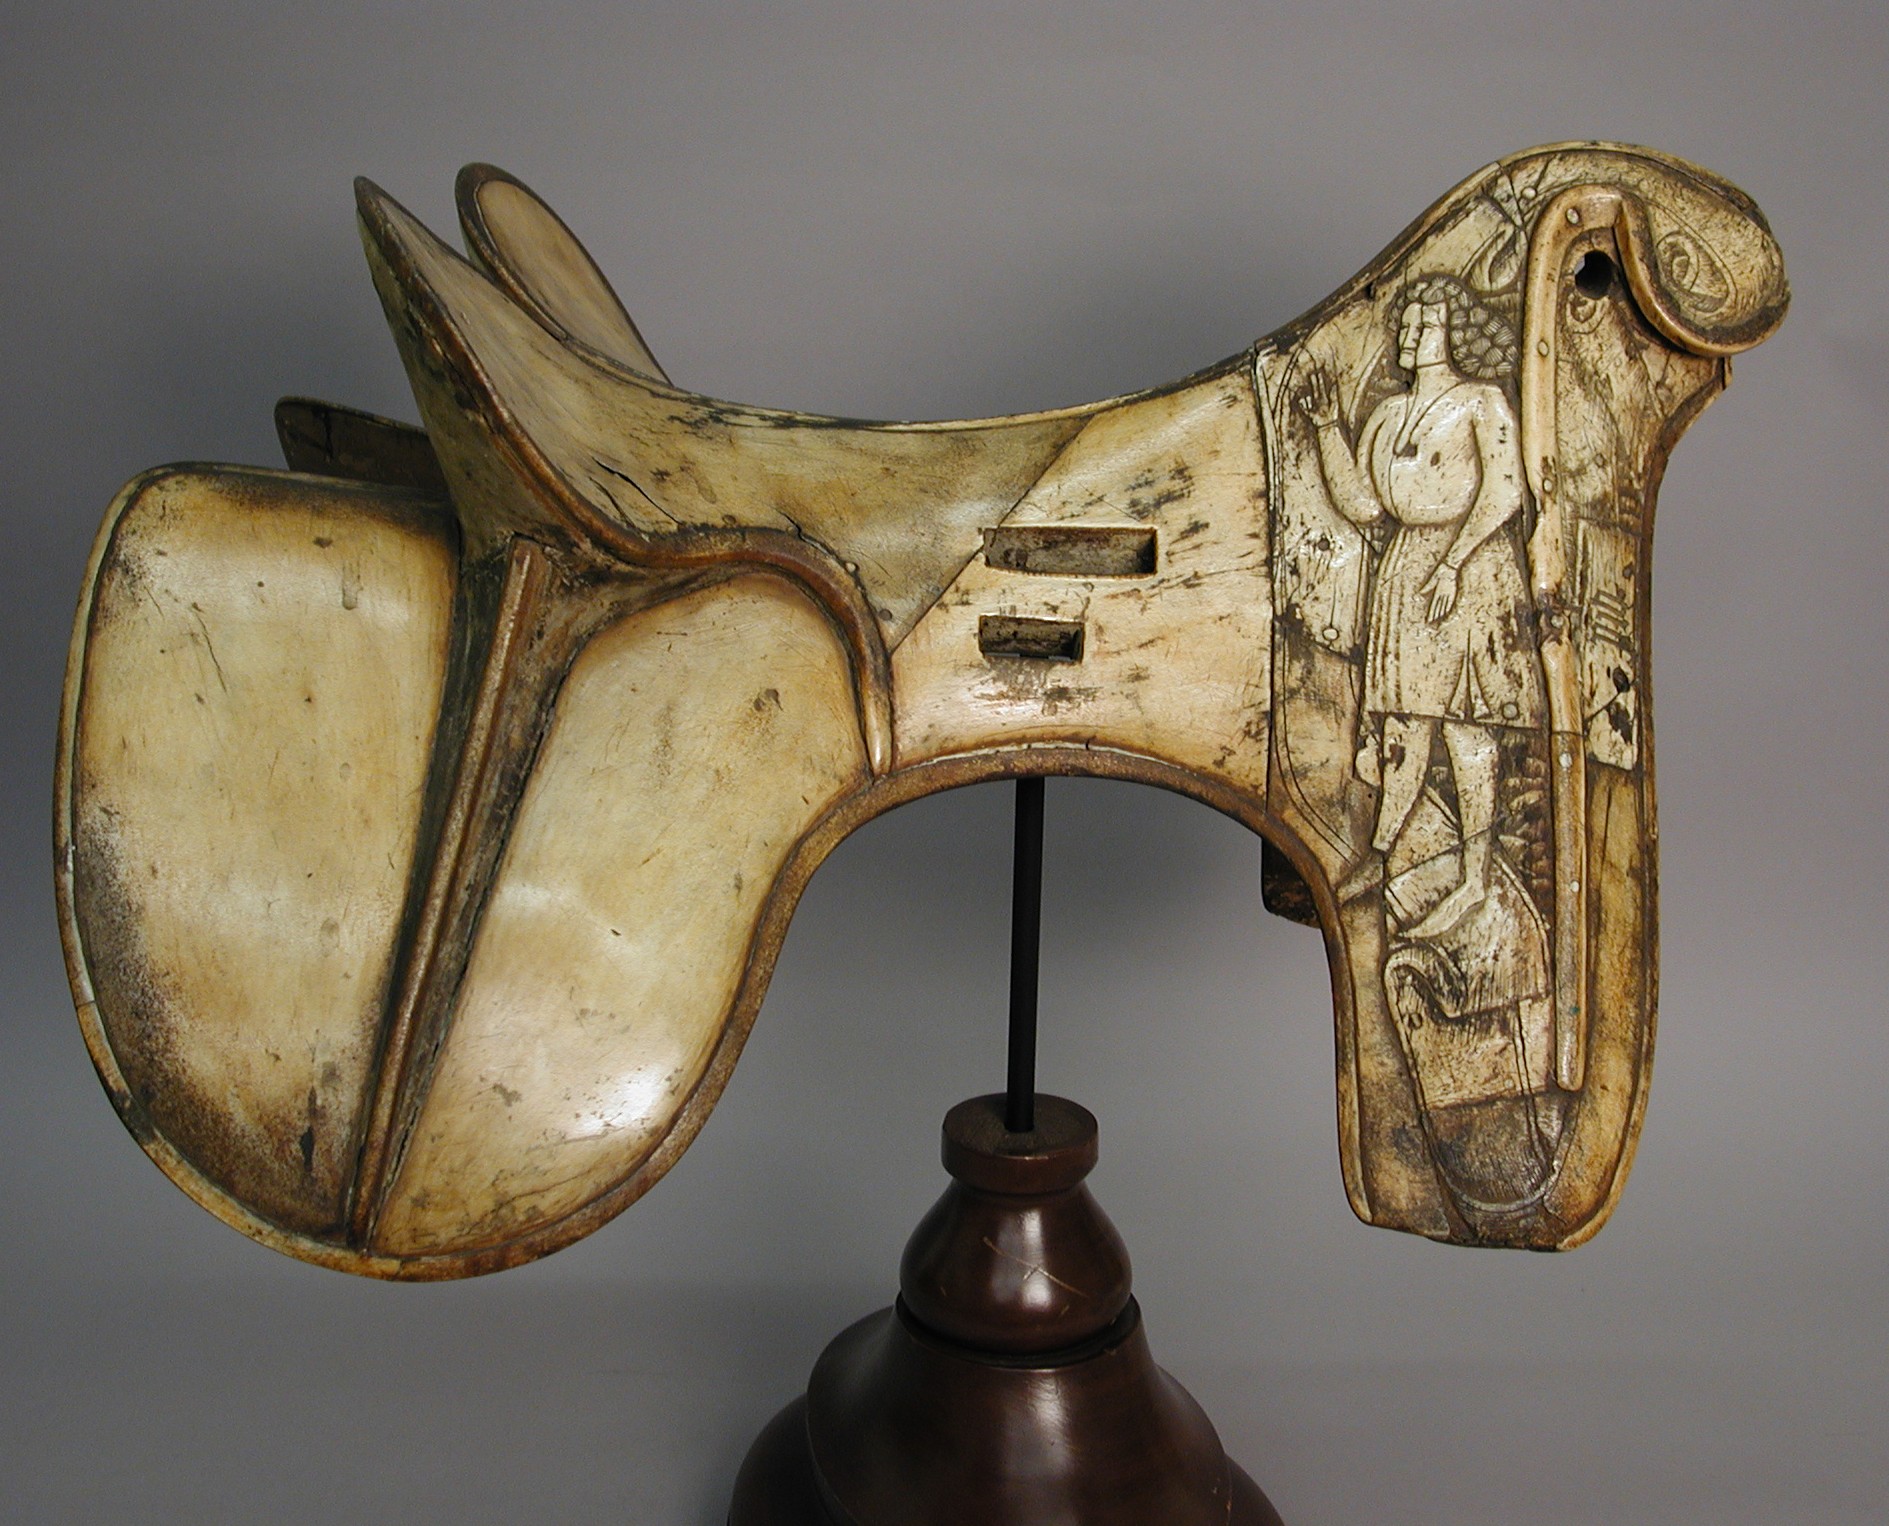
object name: saddle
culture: german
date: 1400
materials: wood, bone, pigment, leather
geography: germany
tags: men